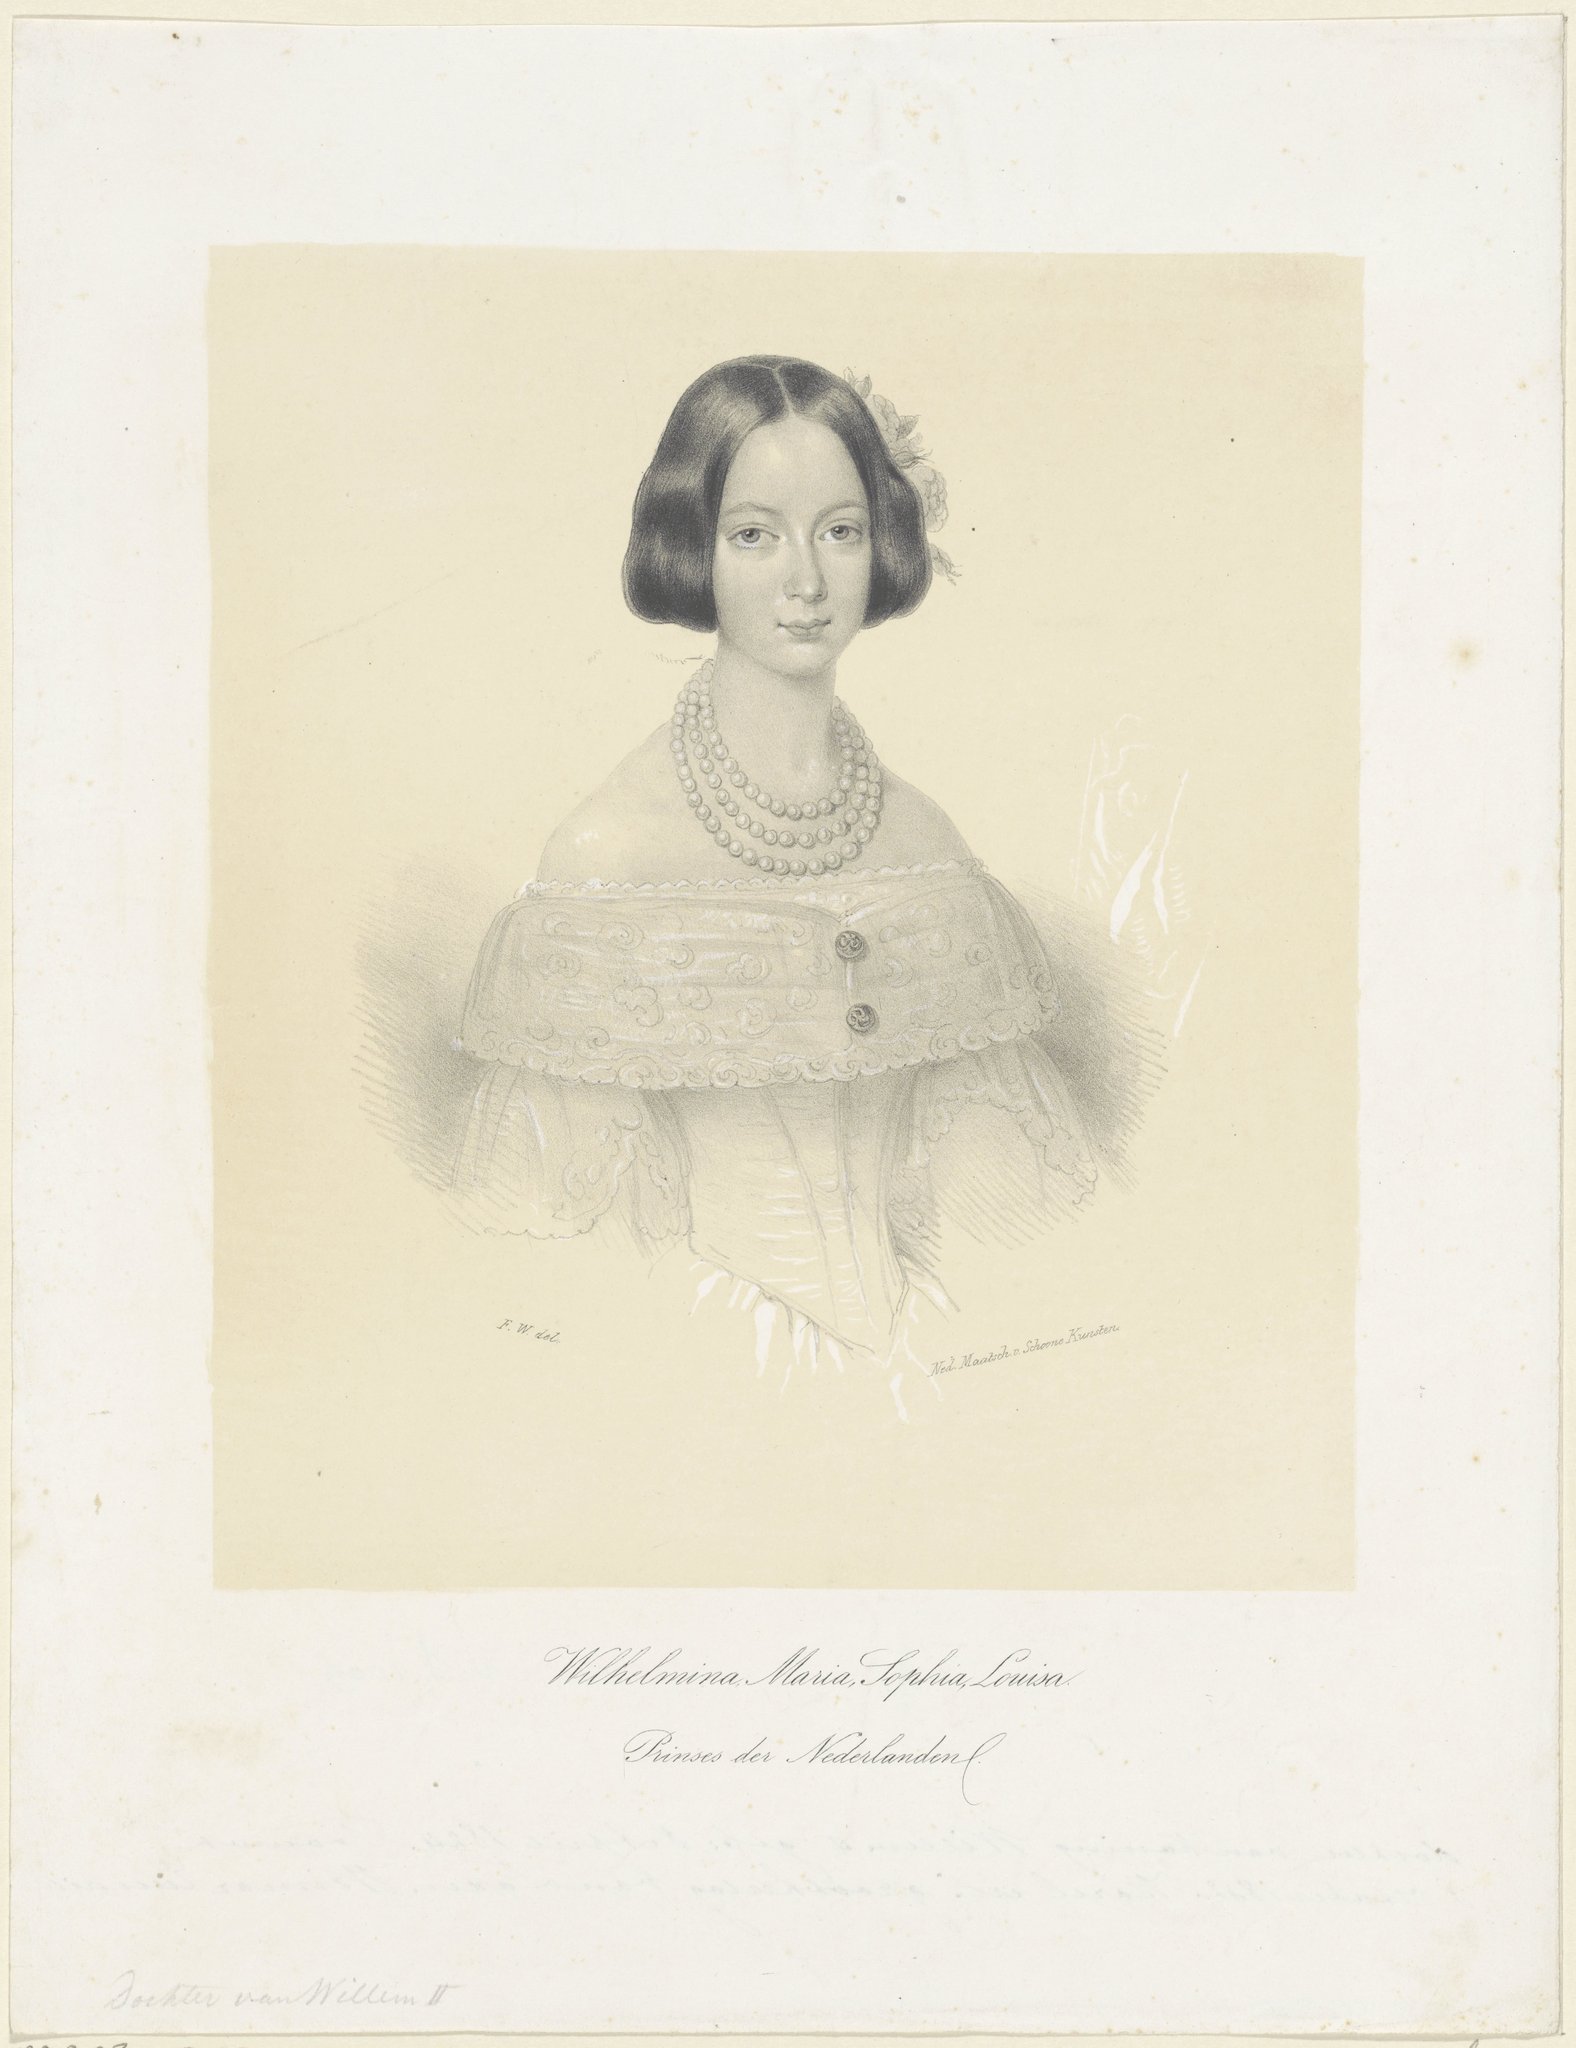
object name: print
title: Portret van Sophie, prinses der Nederlanden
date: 1840-1843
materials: paper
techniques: lithograph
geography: the hague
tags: the hague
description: De hier vermelde titel verwijst naar de hoogst verkregen titel van de geportretteerde, niet per se naar de titel die de geportretteerde op deze voorstelling draagt.